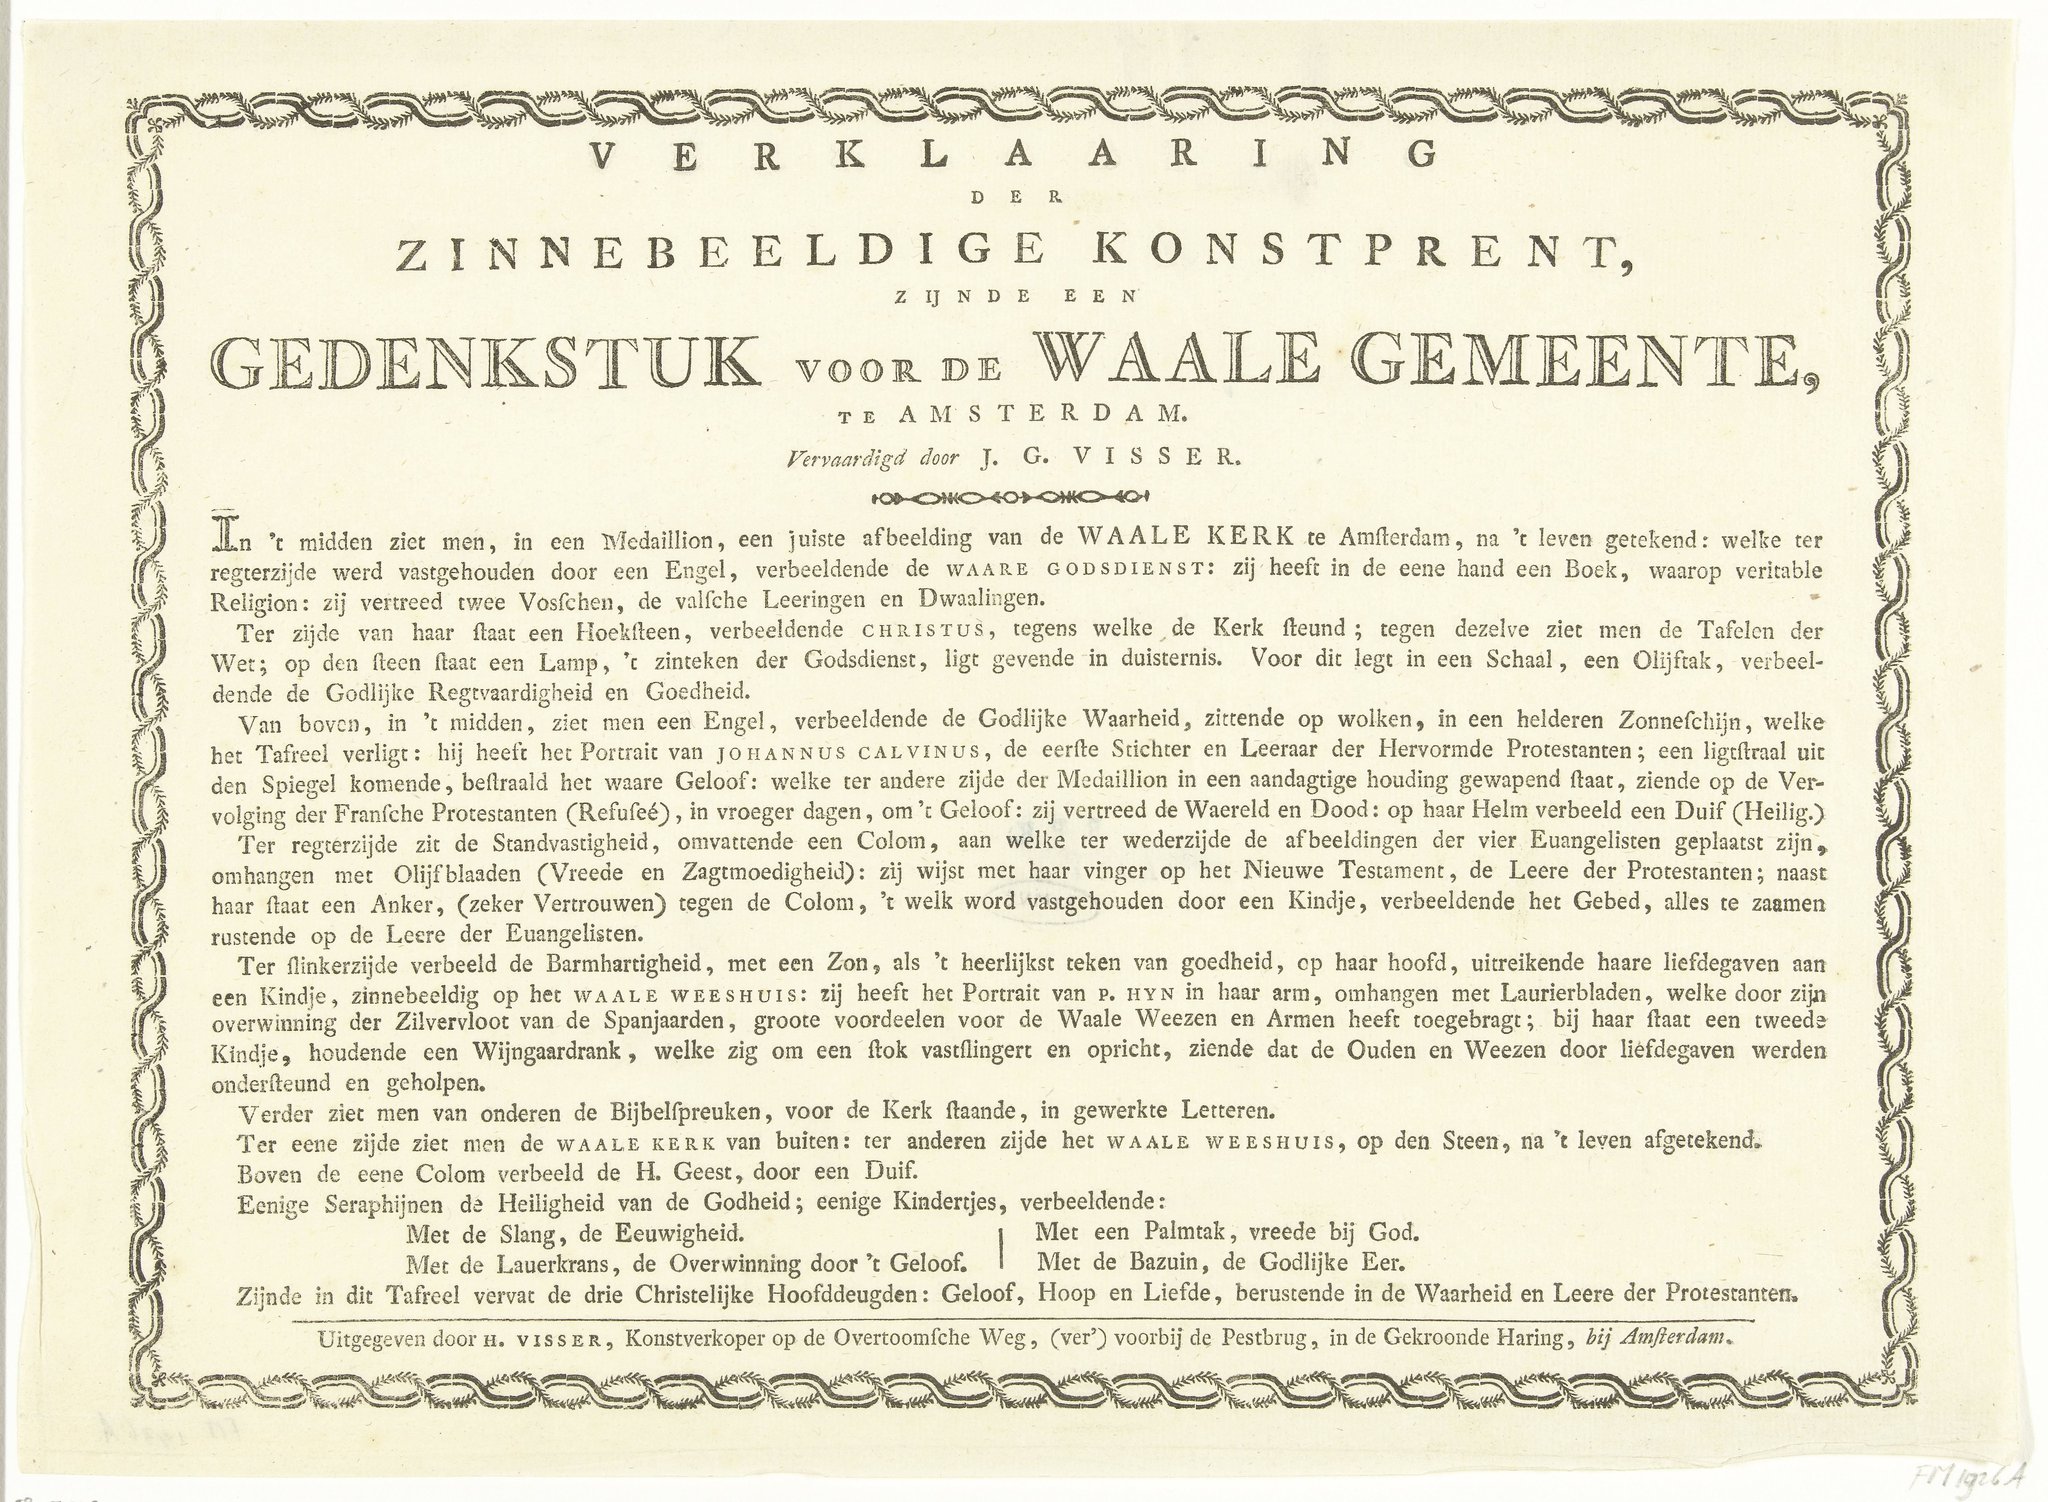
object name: text sheet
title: Verklaaring der Zinnebeeldige Konstprent zijnde een Gedenkstuk voor de Waale Gemeente, te Amsterdam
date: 1800-1821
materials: paper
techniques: letterpress printing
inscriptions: collector's mark: Lugt 2233, collector's mark: Lugt 2228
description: Tekstblad behorende bij de prent met een gedenkstuk voor de Waalse Gemeente te Amsterdam.